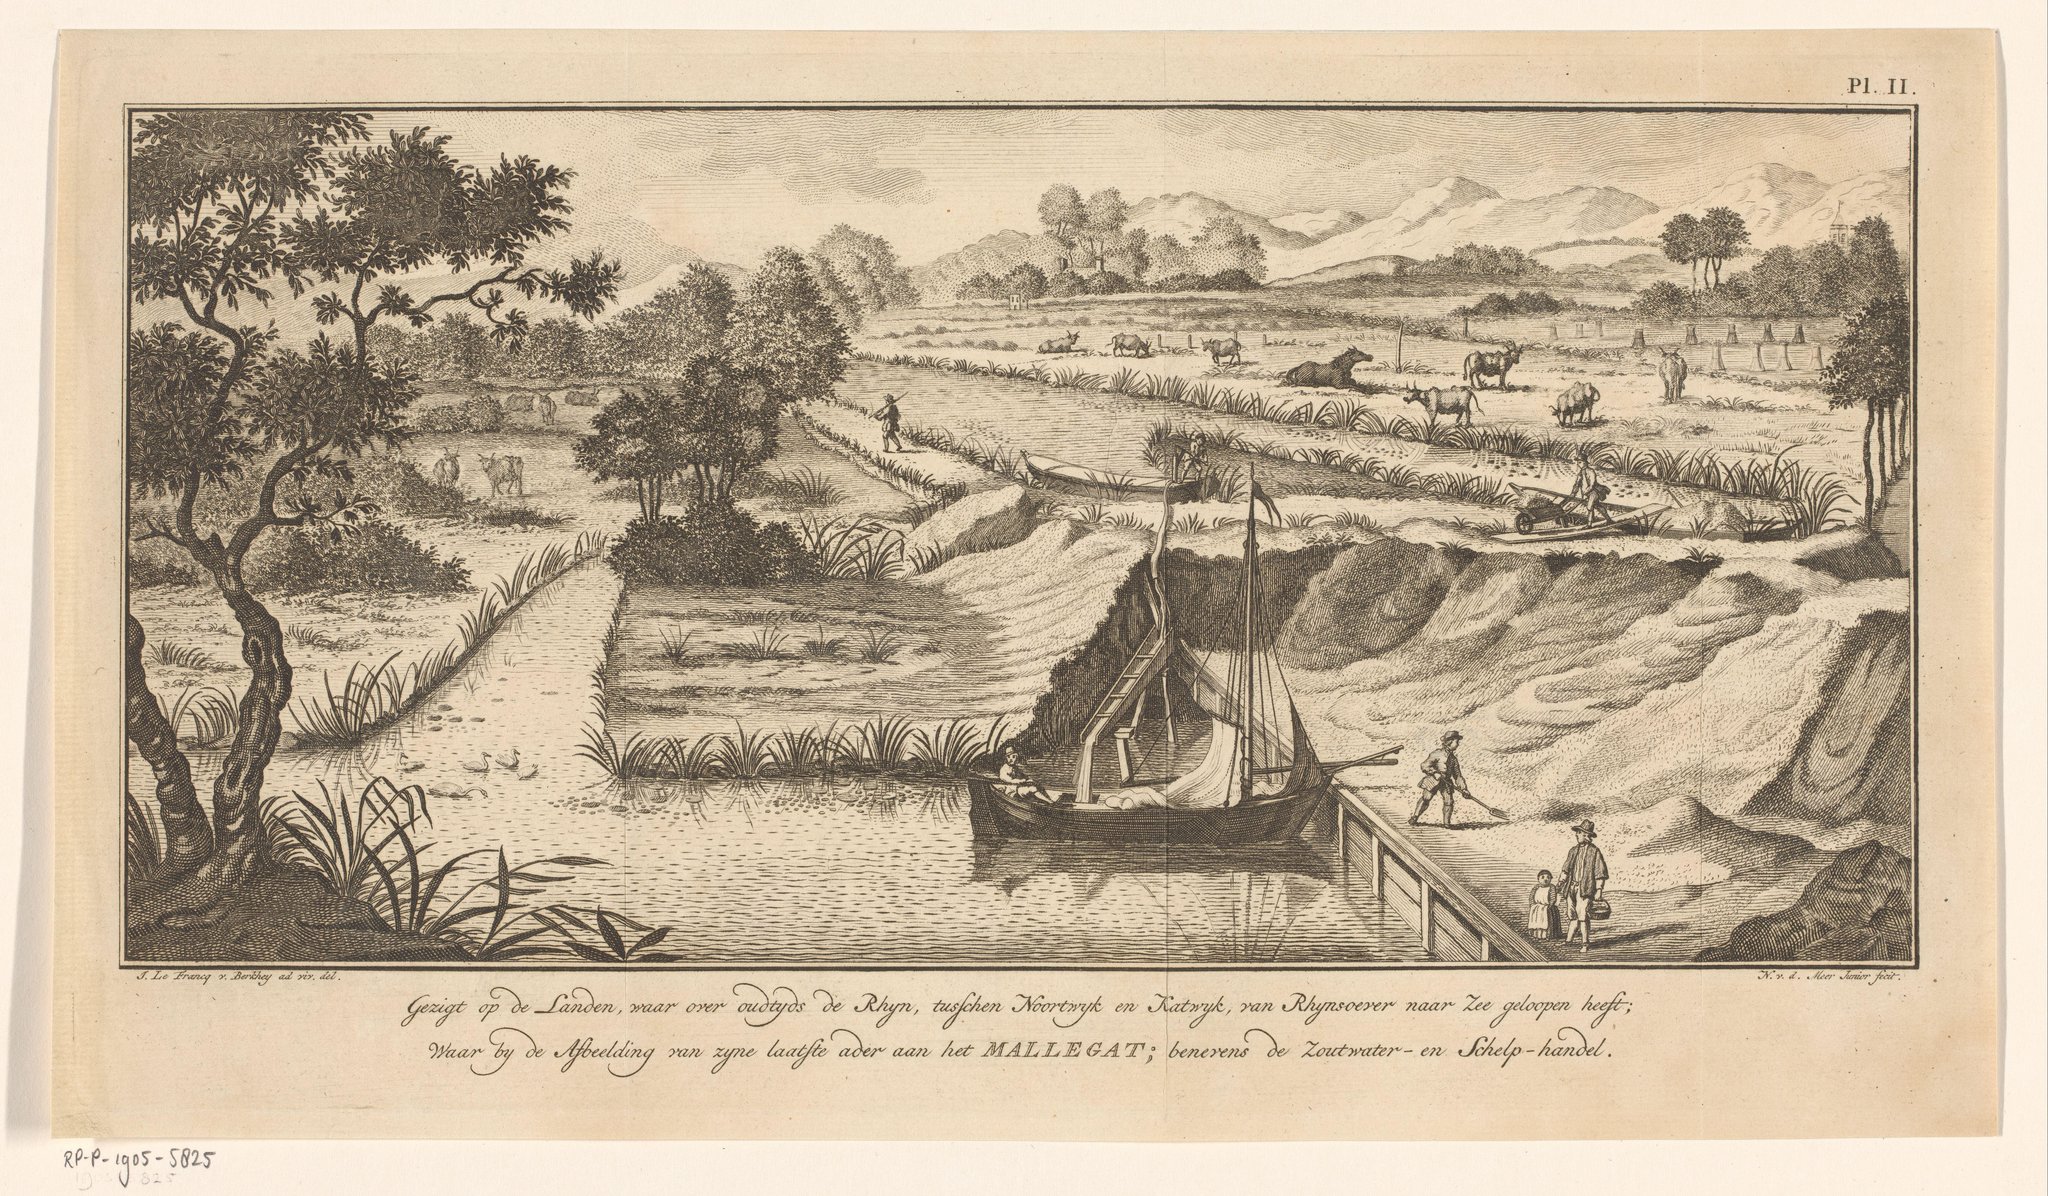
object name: print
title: Oude Rijn bij het Mallegat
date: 1769-1779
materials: paper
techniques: etching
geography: amsterdam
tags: shell fishery (+ materials processed ~ crafts, industries, agriculture), river, merchant shipping, shipping trade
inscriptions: collector's mark: Lugt 2228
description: De landerijen rond het Mallegat en de Oude Rijn tussen Katwijk en Noordwijk. Op de voorgrond wordt een lading van een hoger gelegen in een lager gelegen schip gebracht. Langs de kade liggen bergen schelpen. Op de achtergrond de duinen. Rechtsboven: Pl. II.